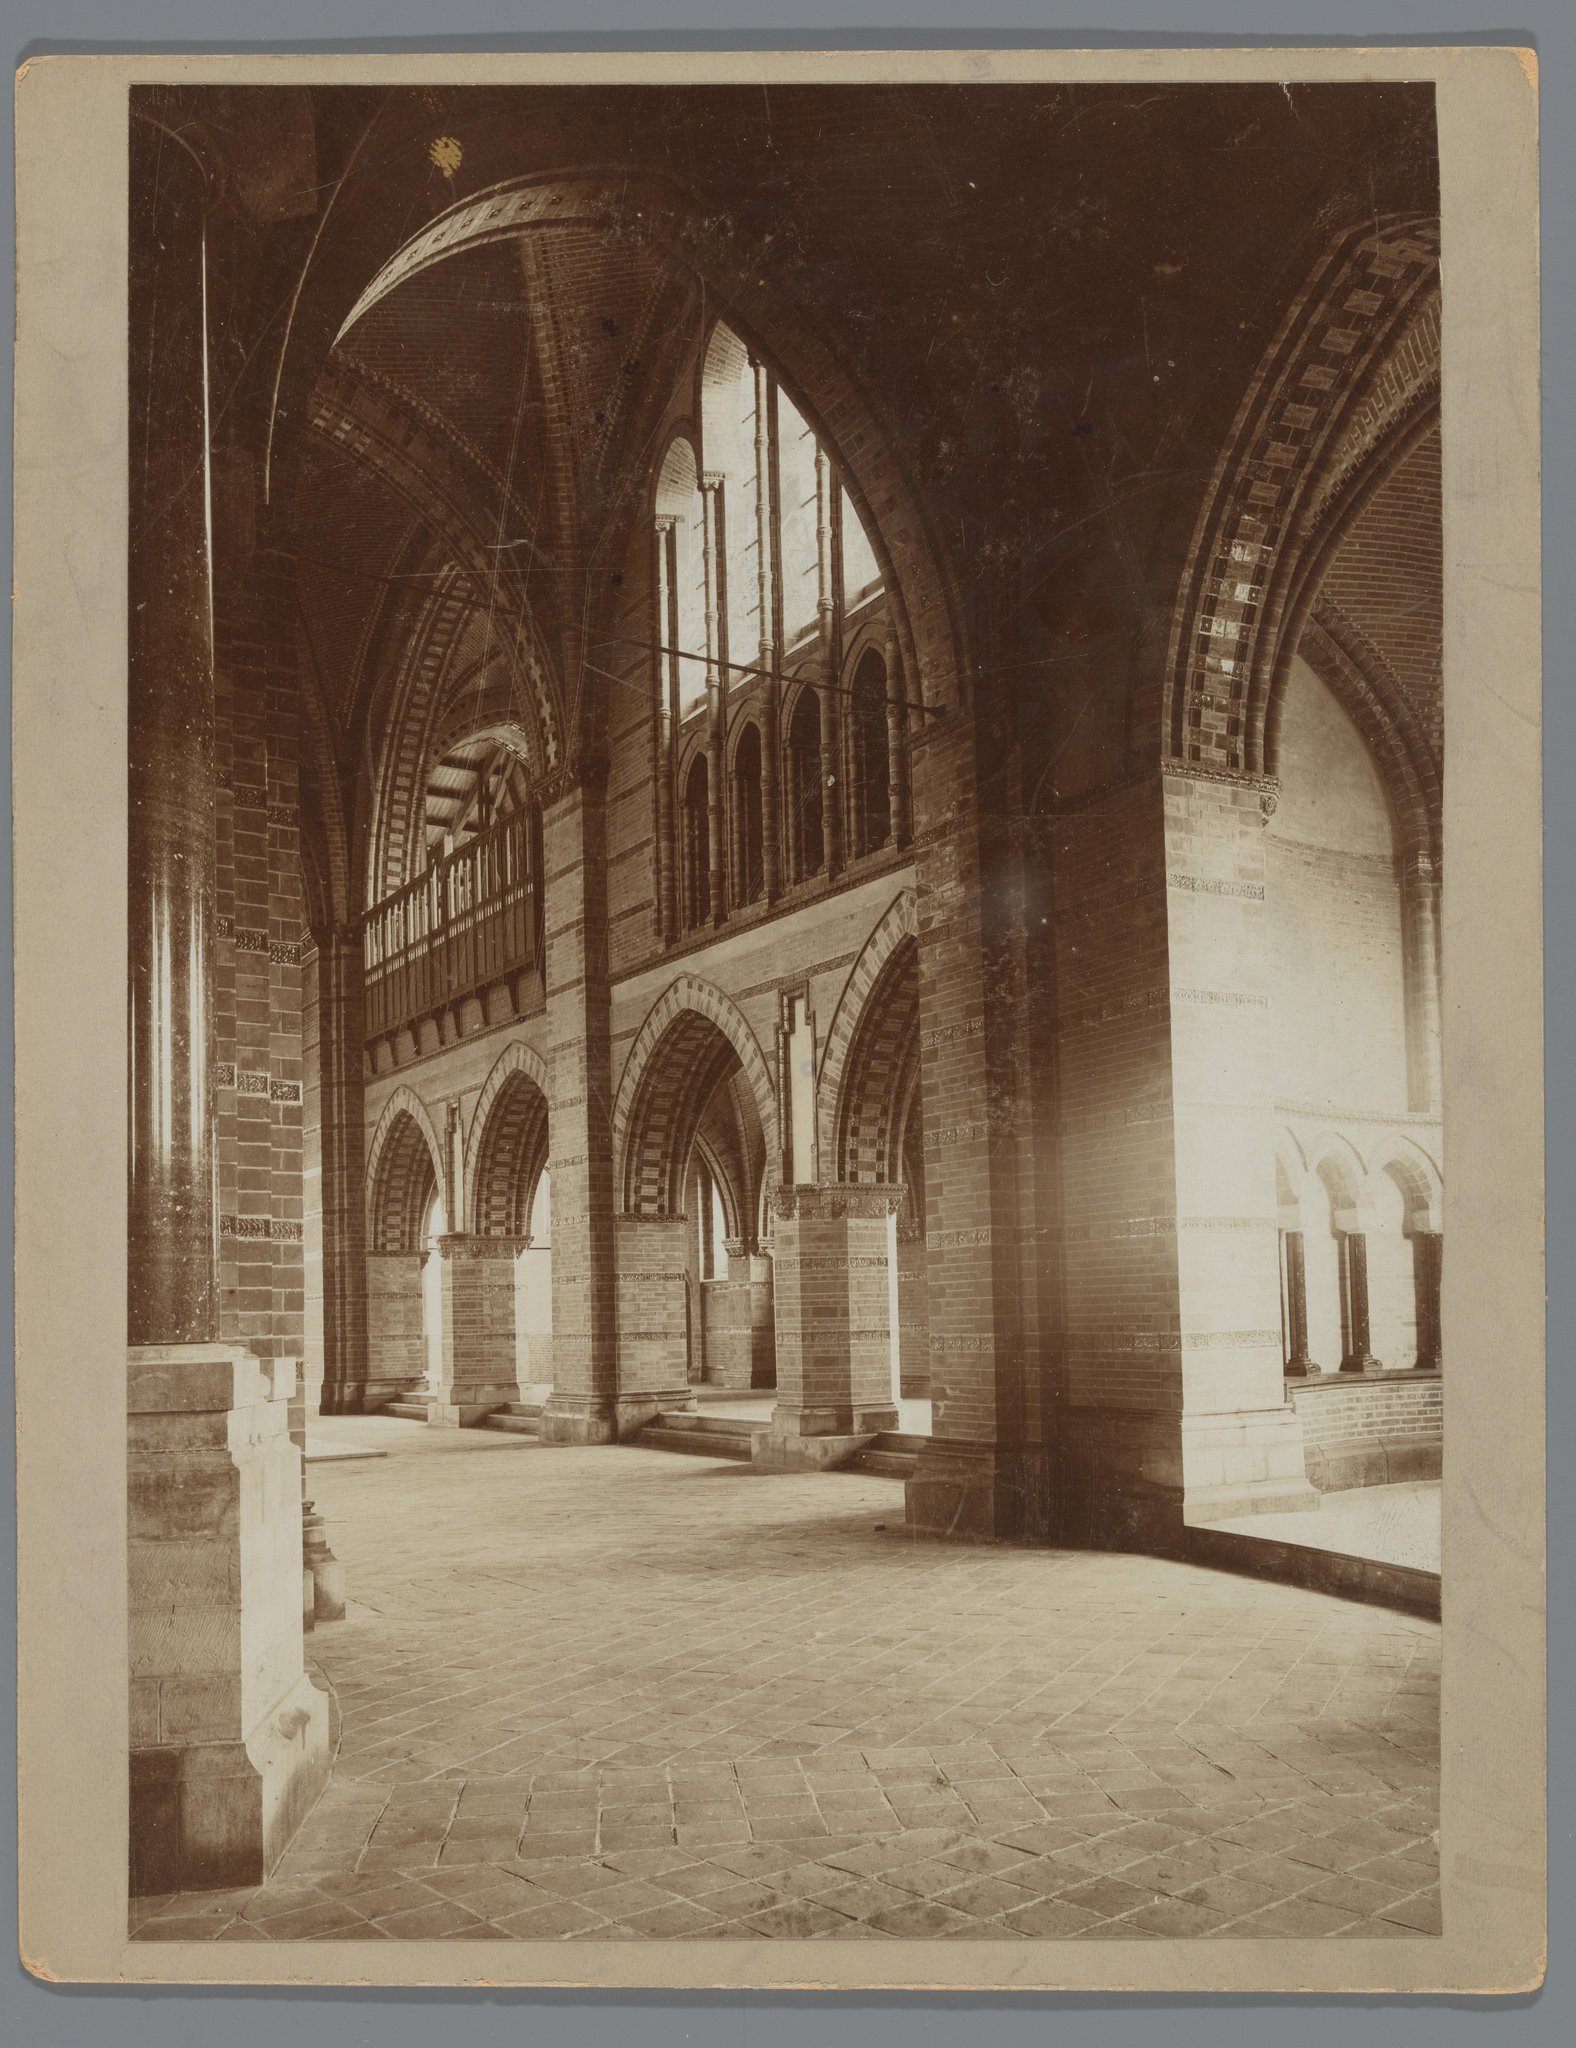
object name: photograph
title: Kerkinterieur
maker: Anonymous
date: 1890-1930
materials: paper, cardboard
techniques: collodion silver print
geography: europe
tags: interior of church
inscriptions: inscription: ‘ubi’